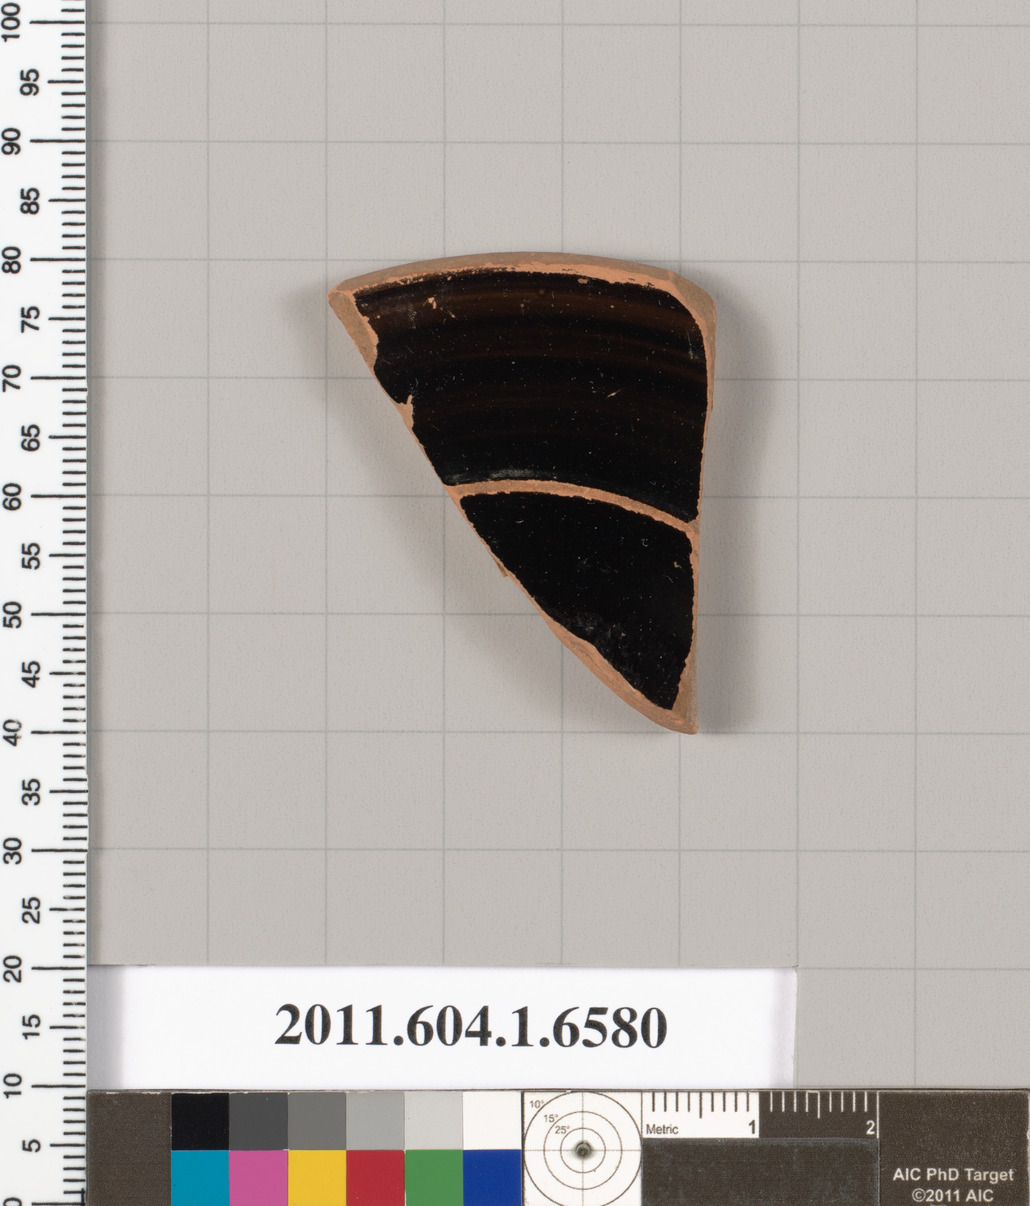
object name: kylix fragment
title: Terracotta fragment of a kylix (drinking cup)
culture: greek, attic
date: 490-480 BCE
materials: terracotta